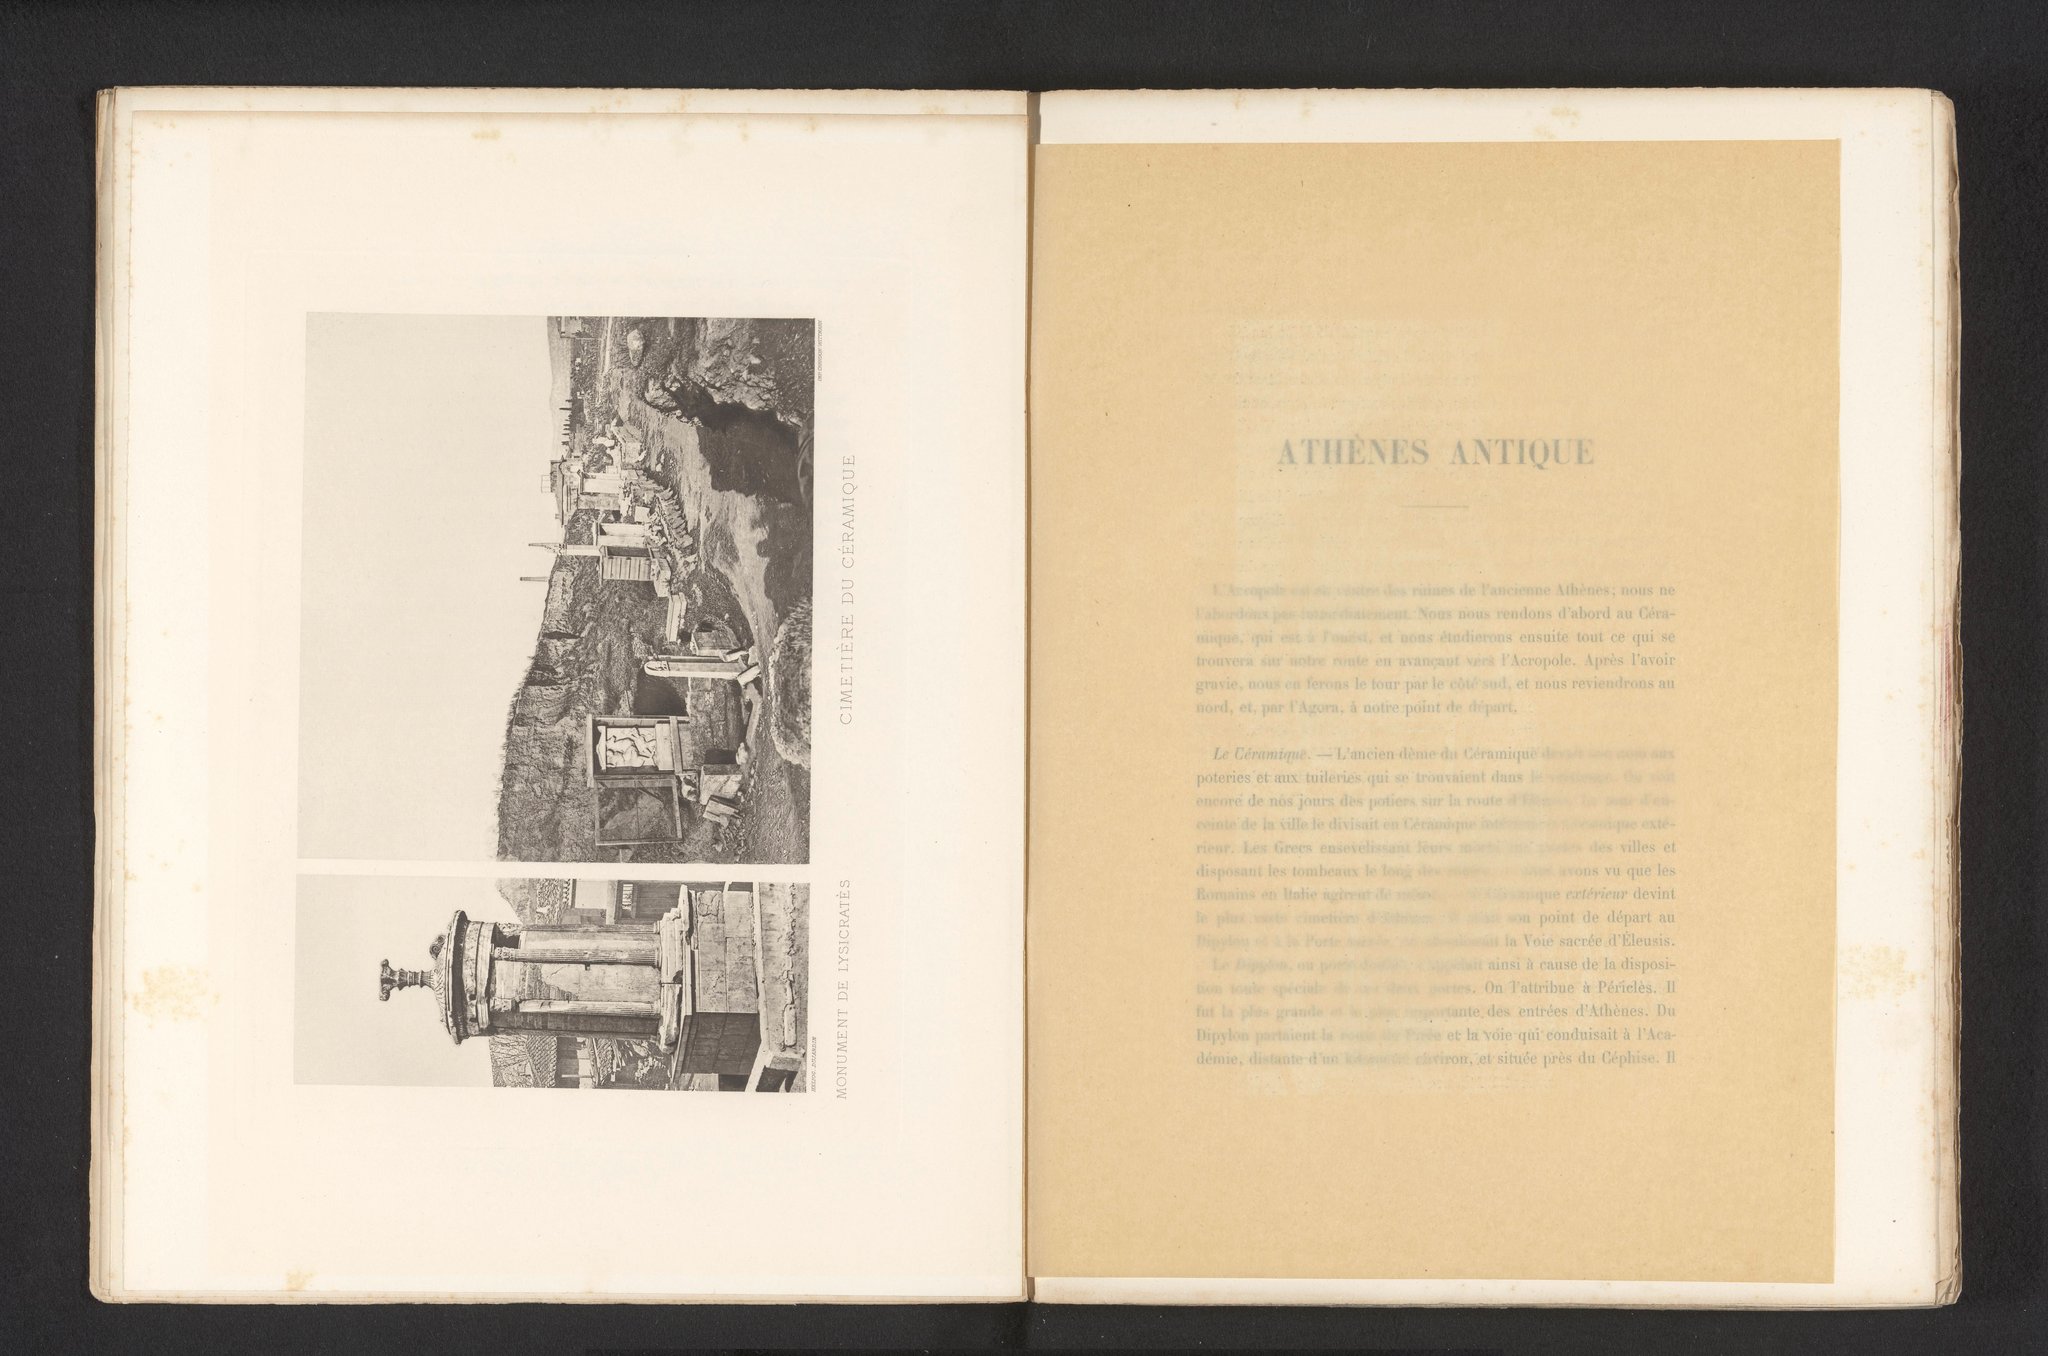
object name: photomechanical print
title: Cimetière du céramique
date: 1880-1890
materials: paper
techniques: photoaquatint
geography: athens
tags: monument, statue, churchyard, cemetery